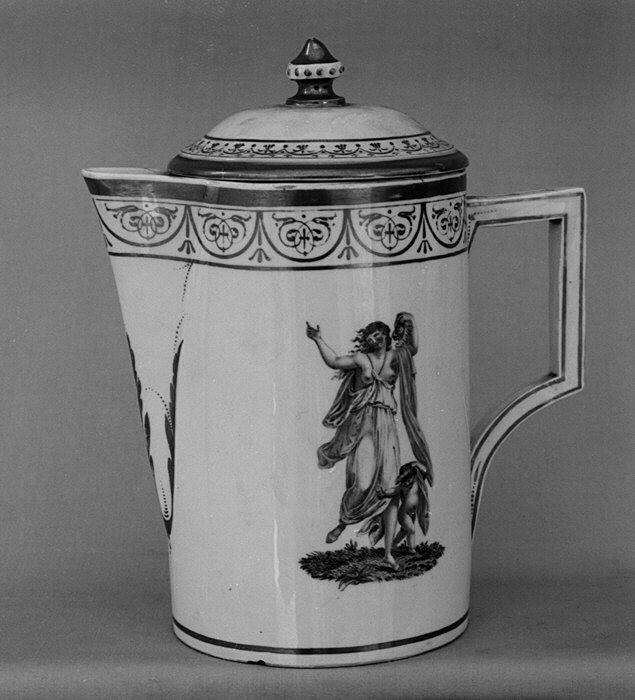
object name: chocolate pot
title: Chocolate pot (?) (part of a coffee service)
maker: nymphenburg porcelain manufactory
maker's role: manufactory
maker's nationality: german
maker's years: 1747-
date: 1801-1833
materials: hard paste porcelain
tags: children,female nudes